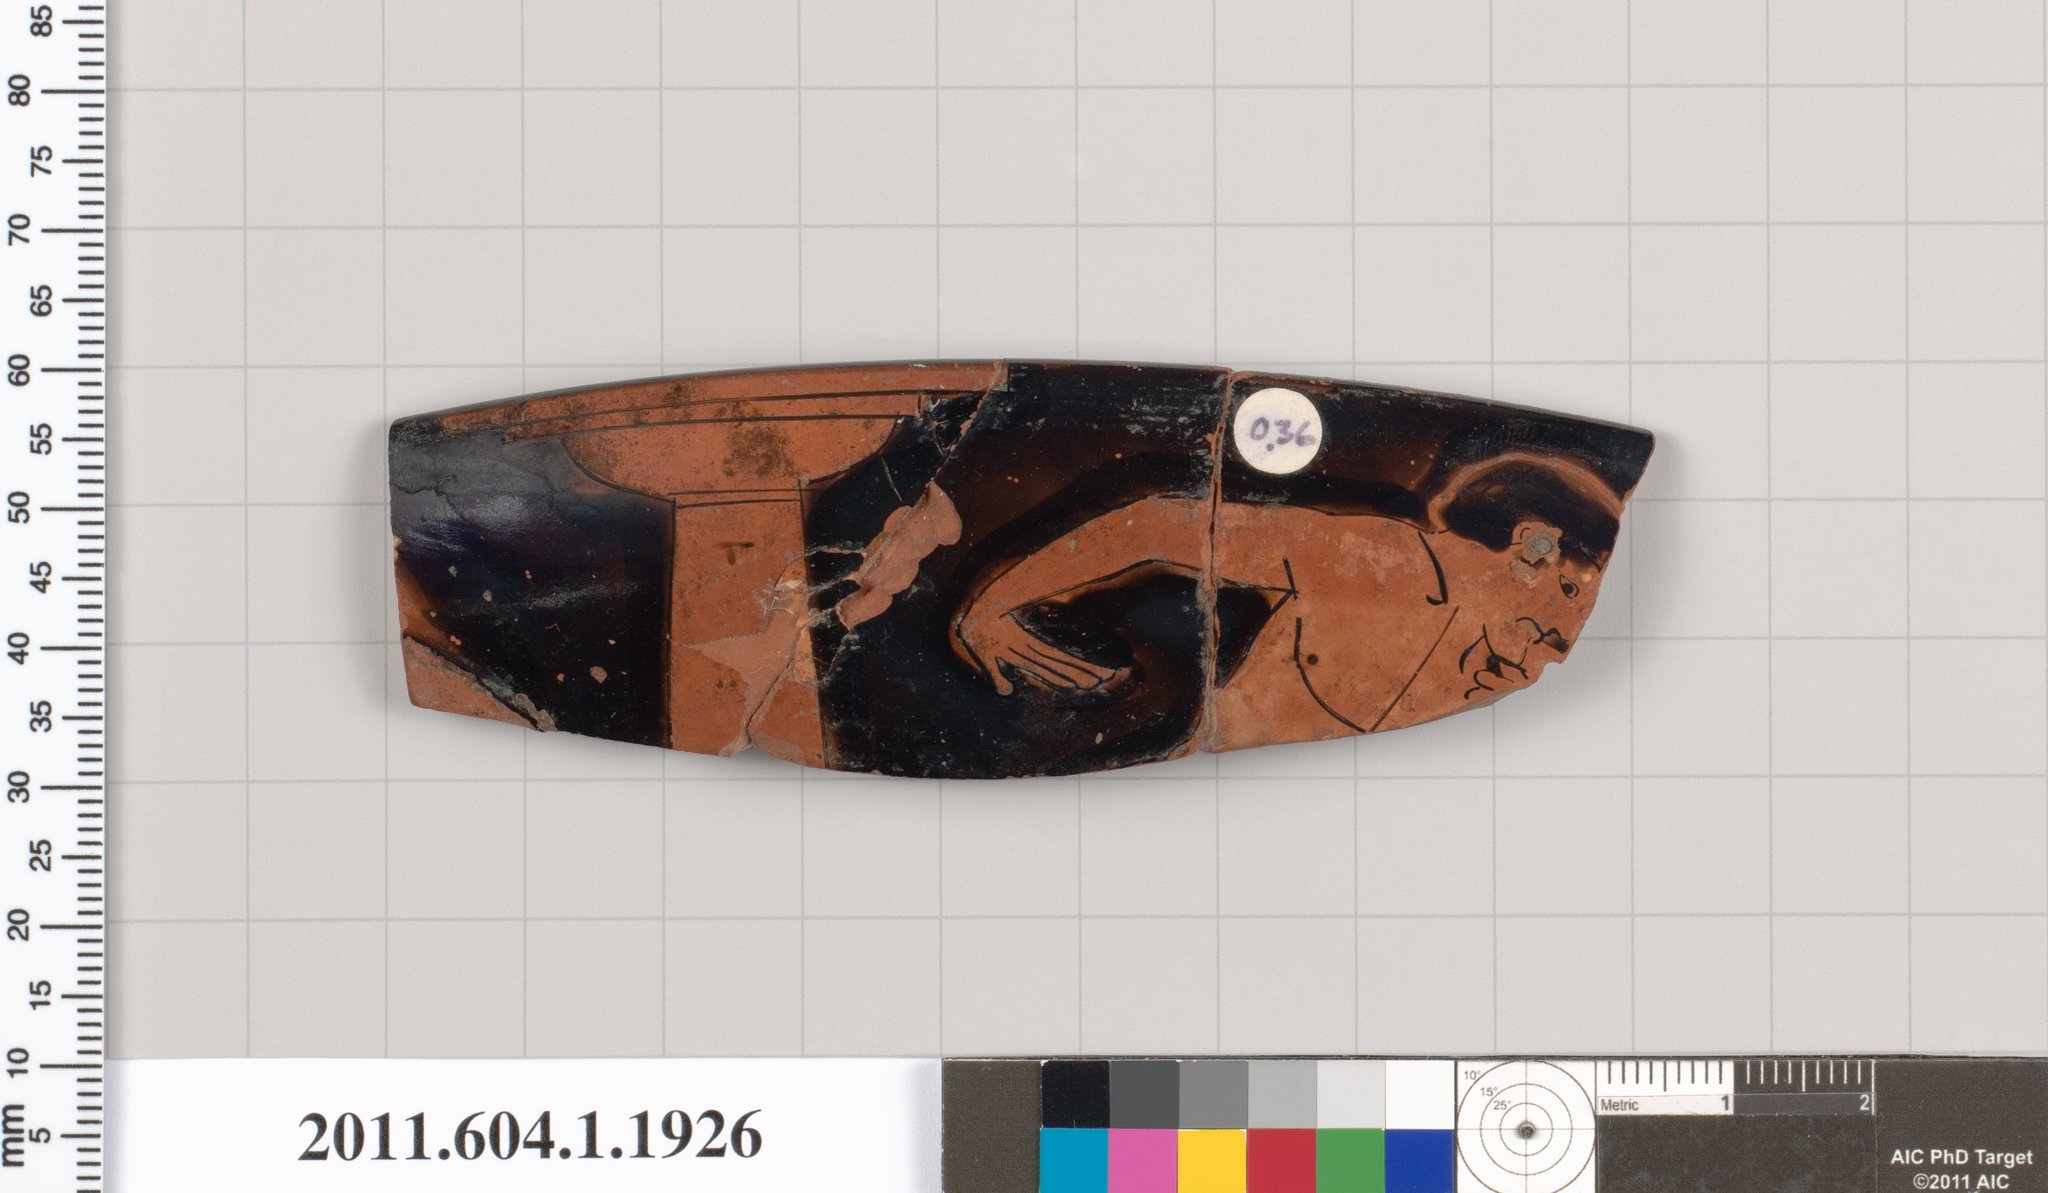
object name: kylix fragment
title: Terracotta rim fragment of a kylix (drinking cup)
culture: greek, attic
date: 534-468 BCE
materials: terracotta